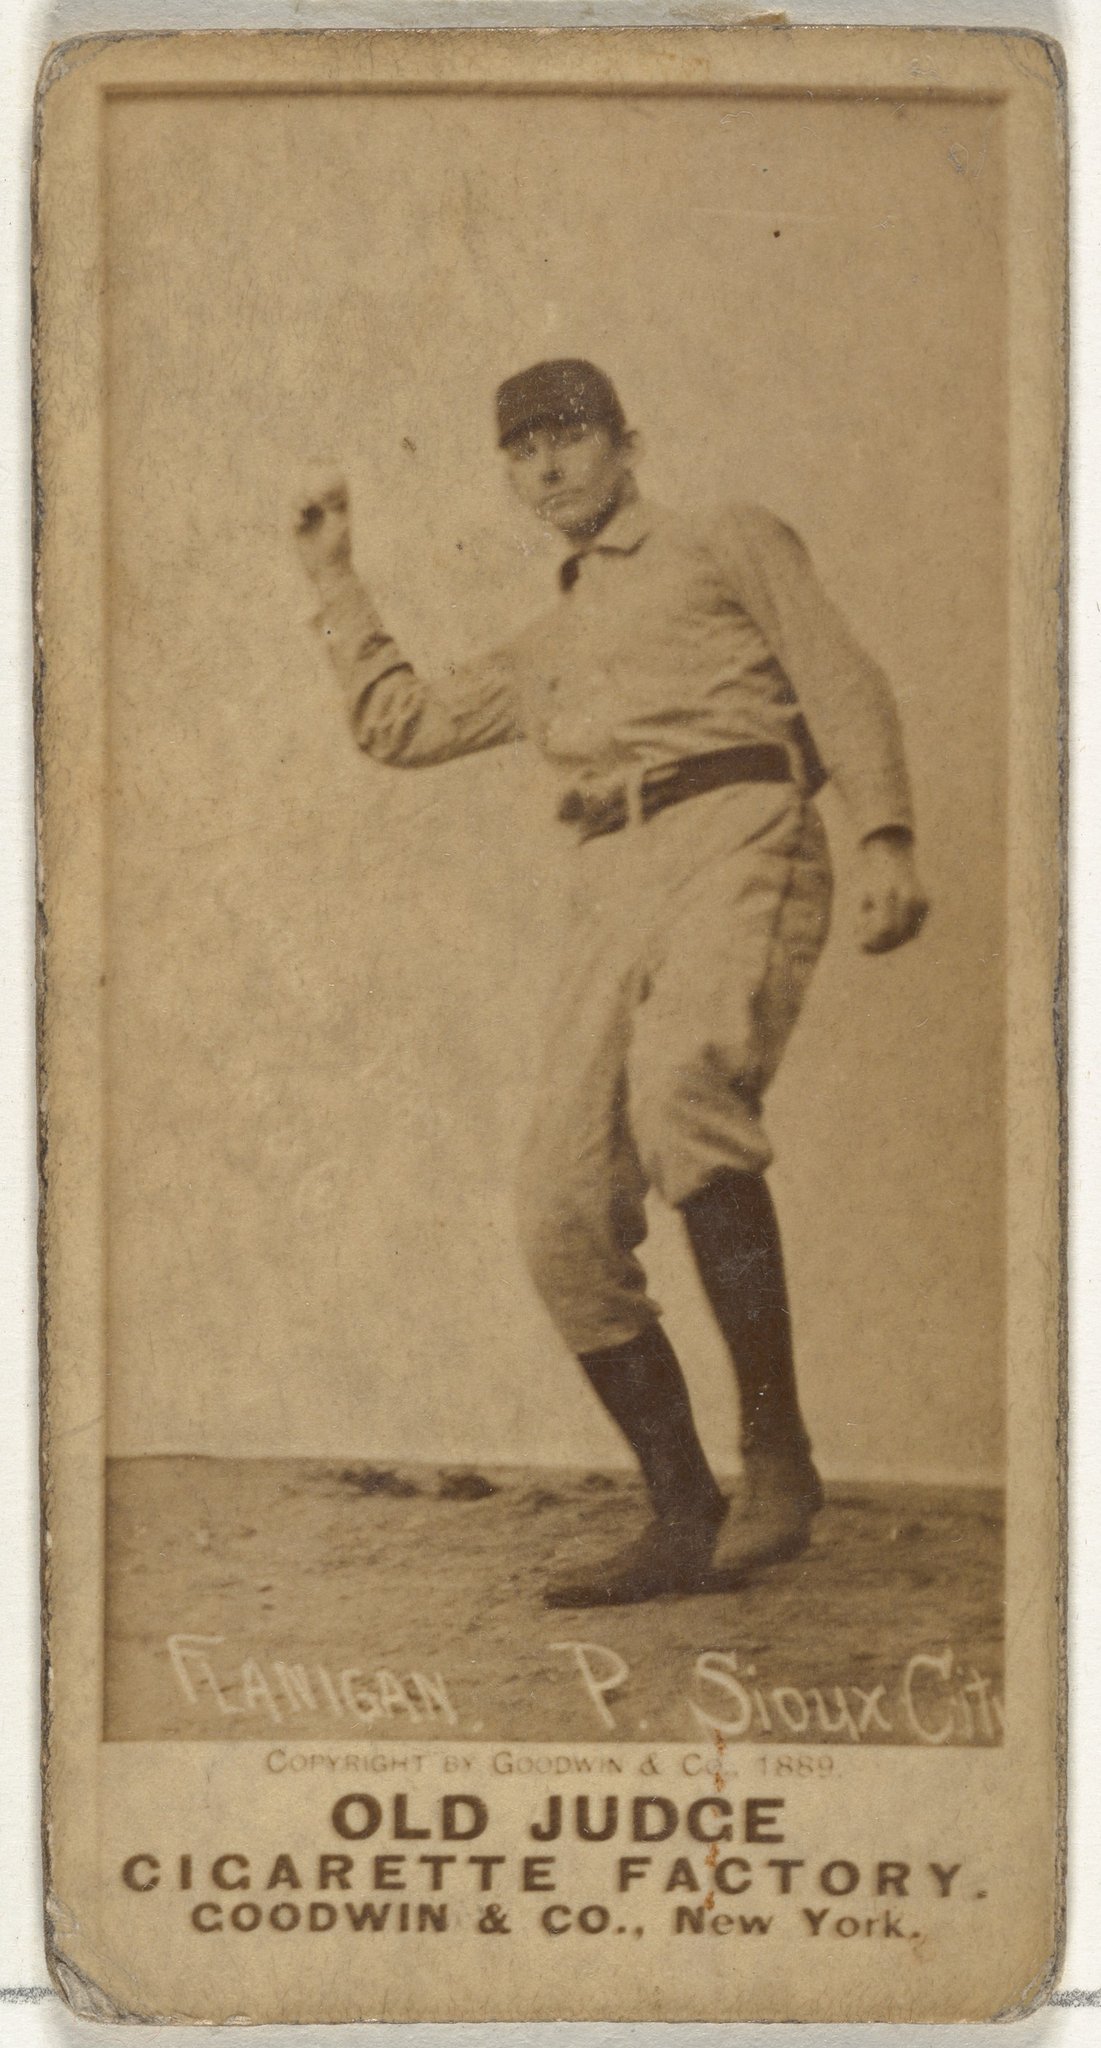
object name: baseball card, photograph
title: Thomas Flanagan, Pitcher, Sioux City Corn Huskers, from the Old Judge series (N172) for Old Judge Cigarettes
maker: goodwin & company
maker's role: publisher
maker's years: 1850-1950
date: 1889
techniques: albumen silver print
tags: men,portraits,baseball,athletes